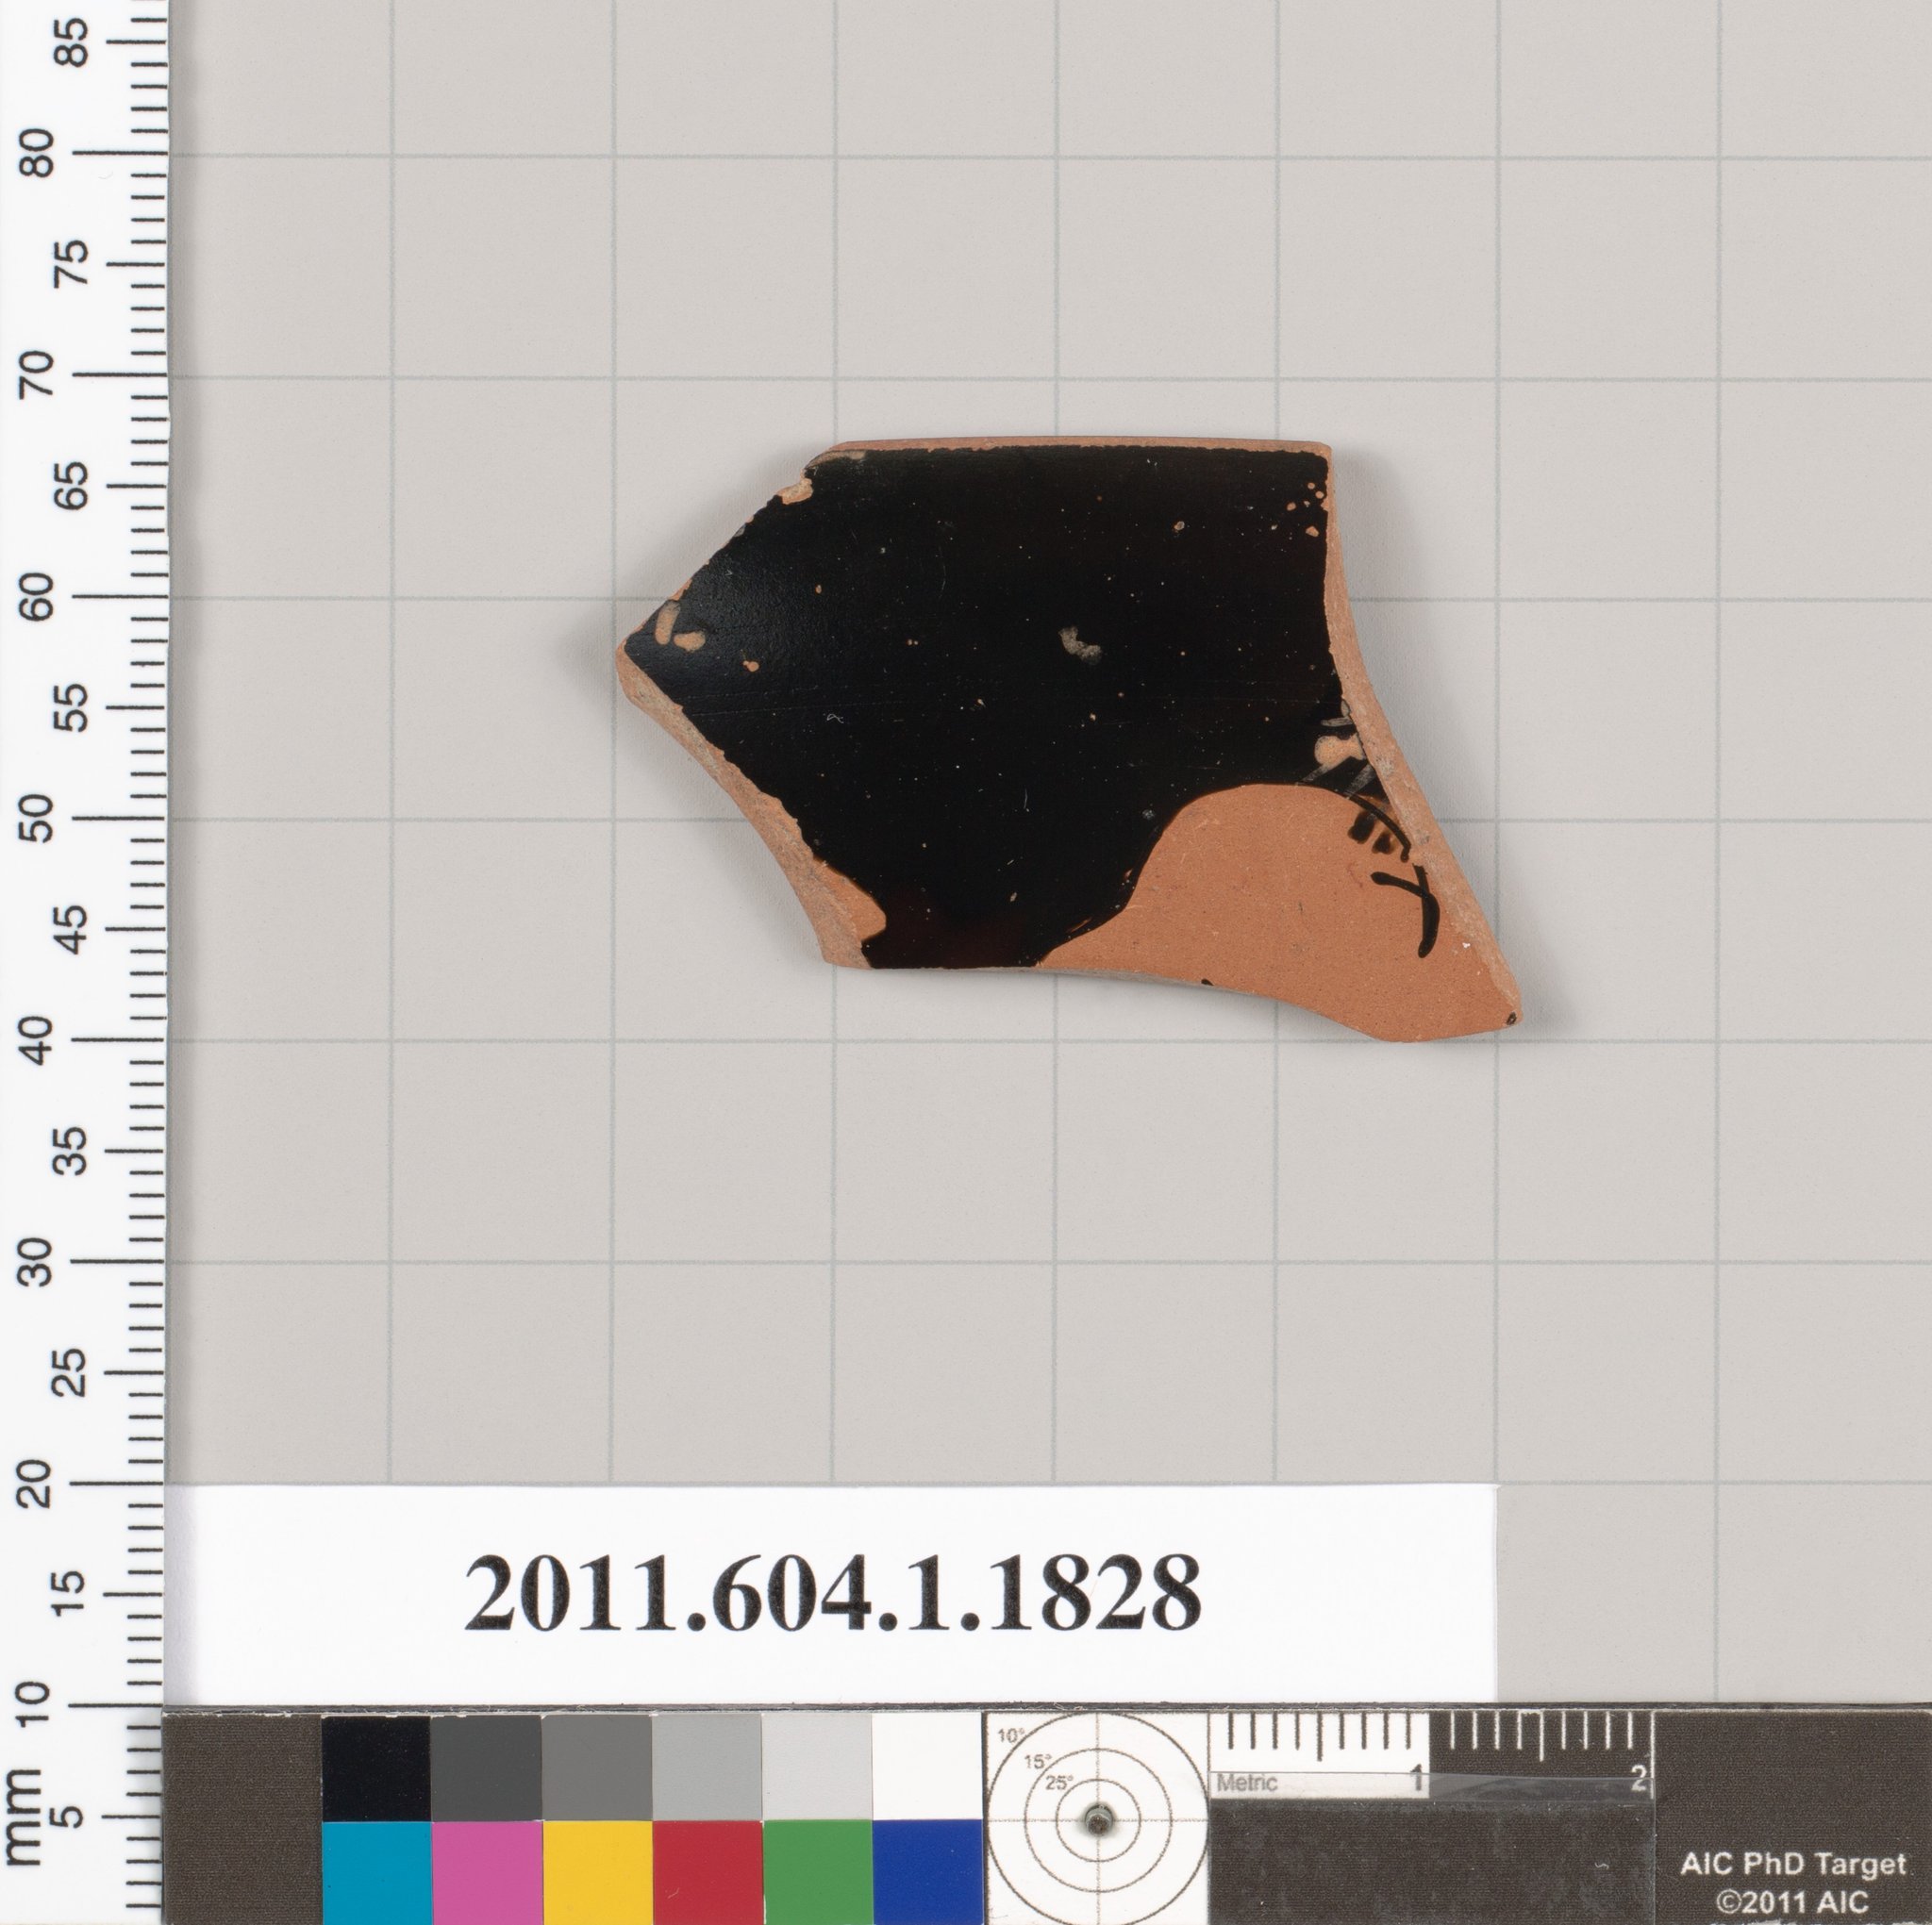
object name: kylix fragment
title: Terracotta rim fragment of a kylix (drinking cup)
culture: greek, attic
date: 475-451 BCE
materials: terracotta